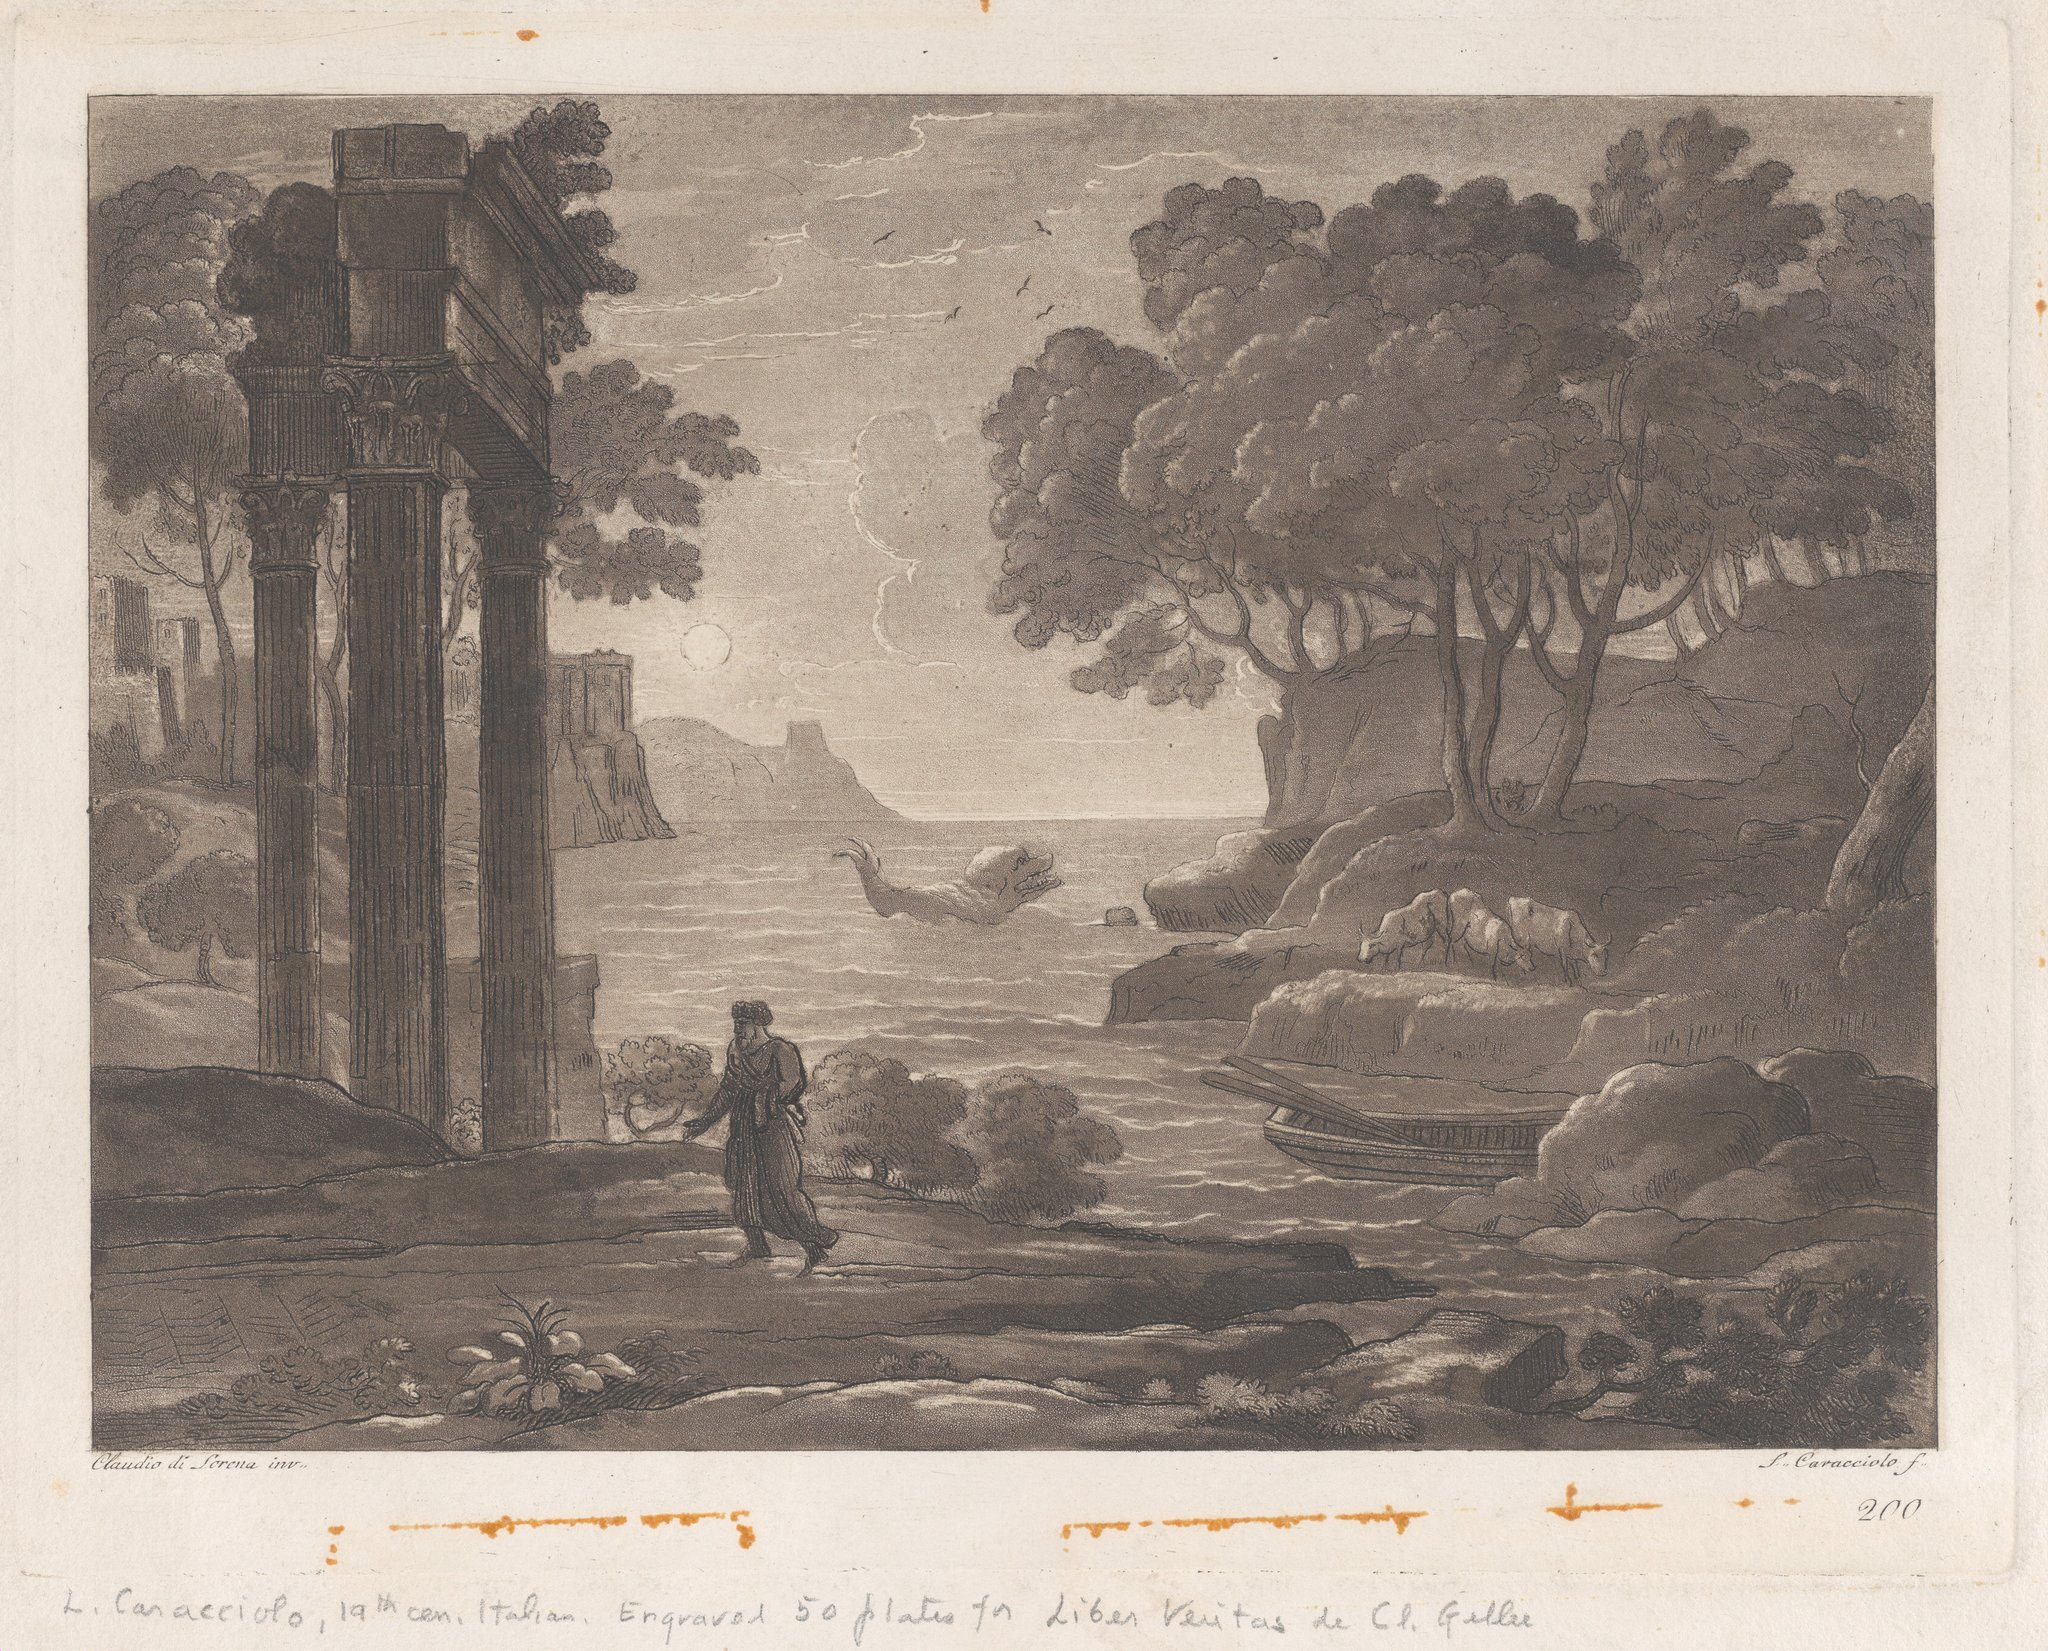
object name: print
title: Seascape, after Claude Lorrain's "Liber Veritatis"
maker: ludovico caracciolo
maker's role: artist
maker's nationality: italian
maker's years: 1761-1842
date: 1815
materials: ink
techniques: aquatint, etching, printing